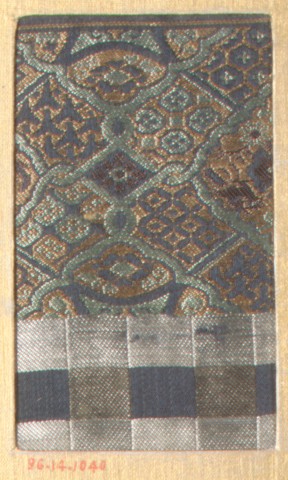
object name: piece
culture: japanese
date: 1701-1900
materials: silk